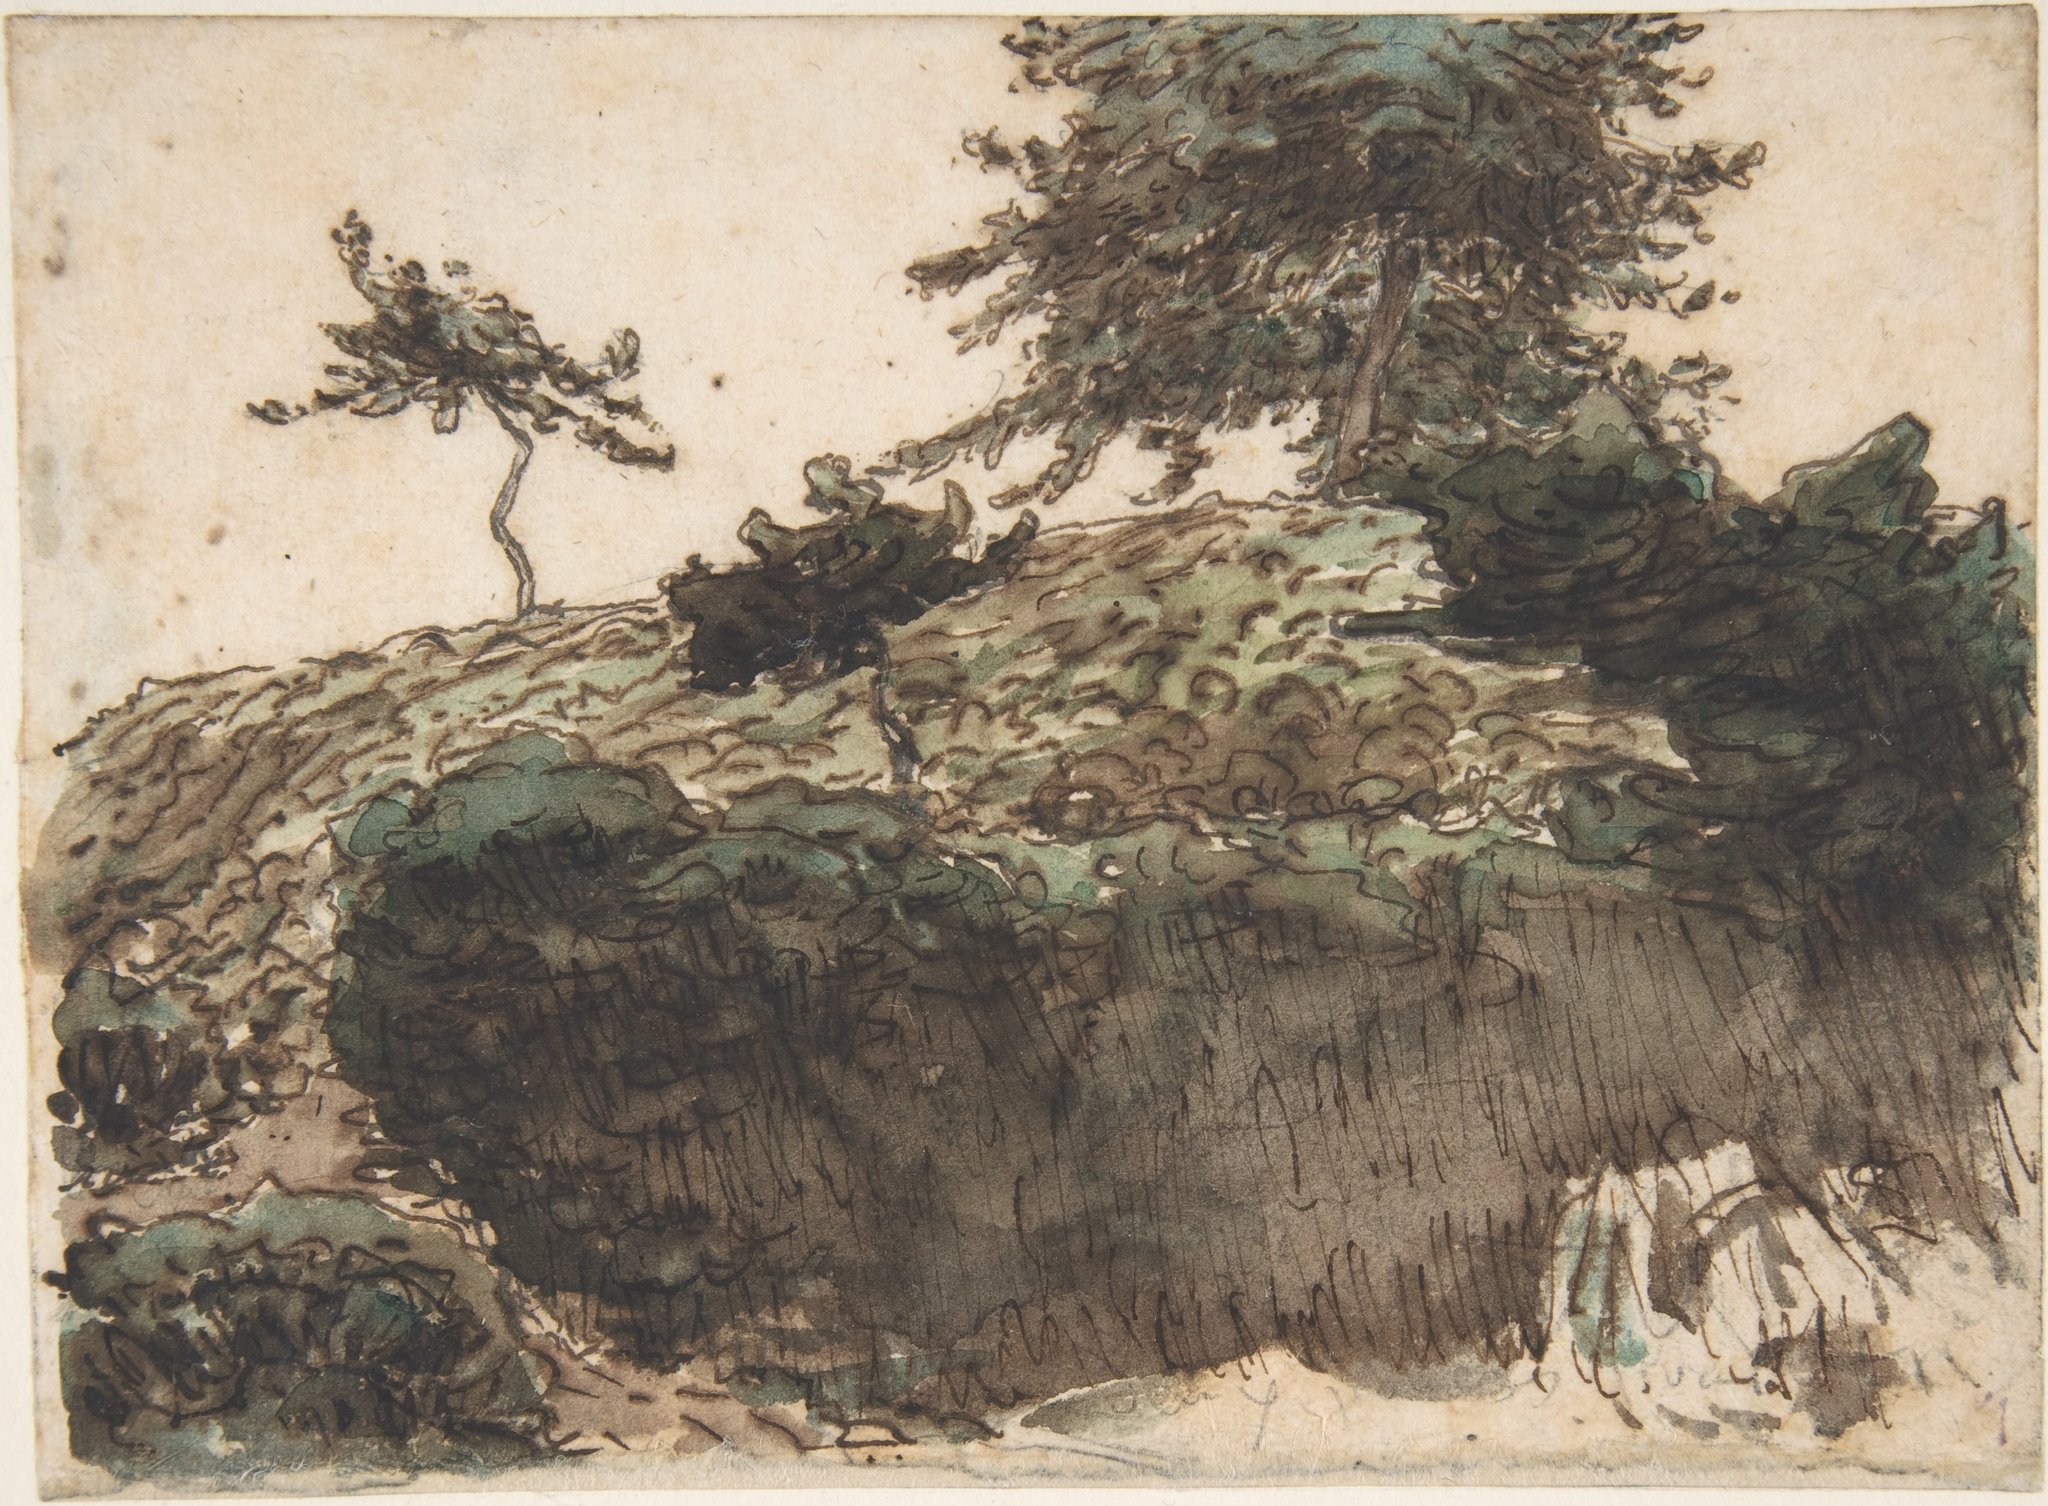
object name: drawing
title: Landscape, Vichy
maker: jean-françois millet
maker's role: artist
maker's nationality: french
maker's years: 1814-1875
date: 1866-1867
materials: graphite, ink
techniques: brush, pen, wash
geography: france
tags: landscapes,trees